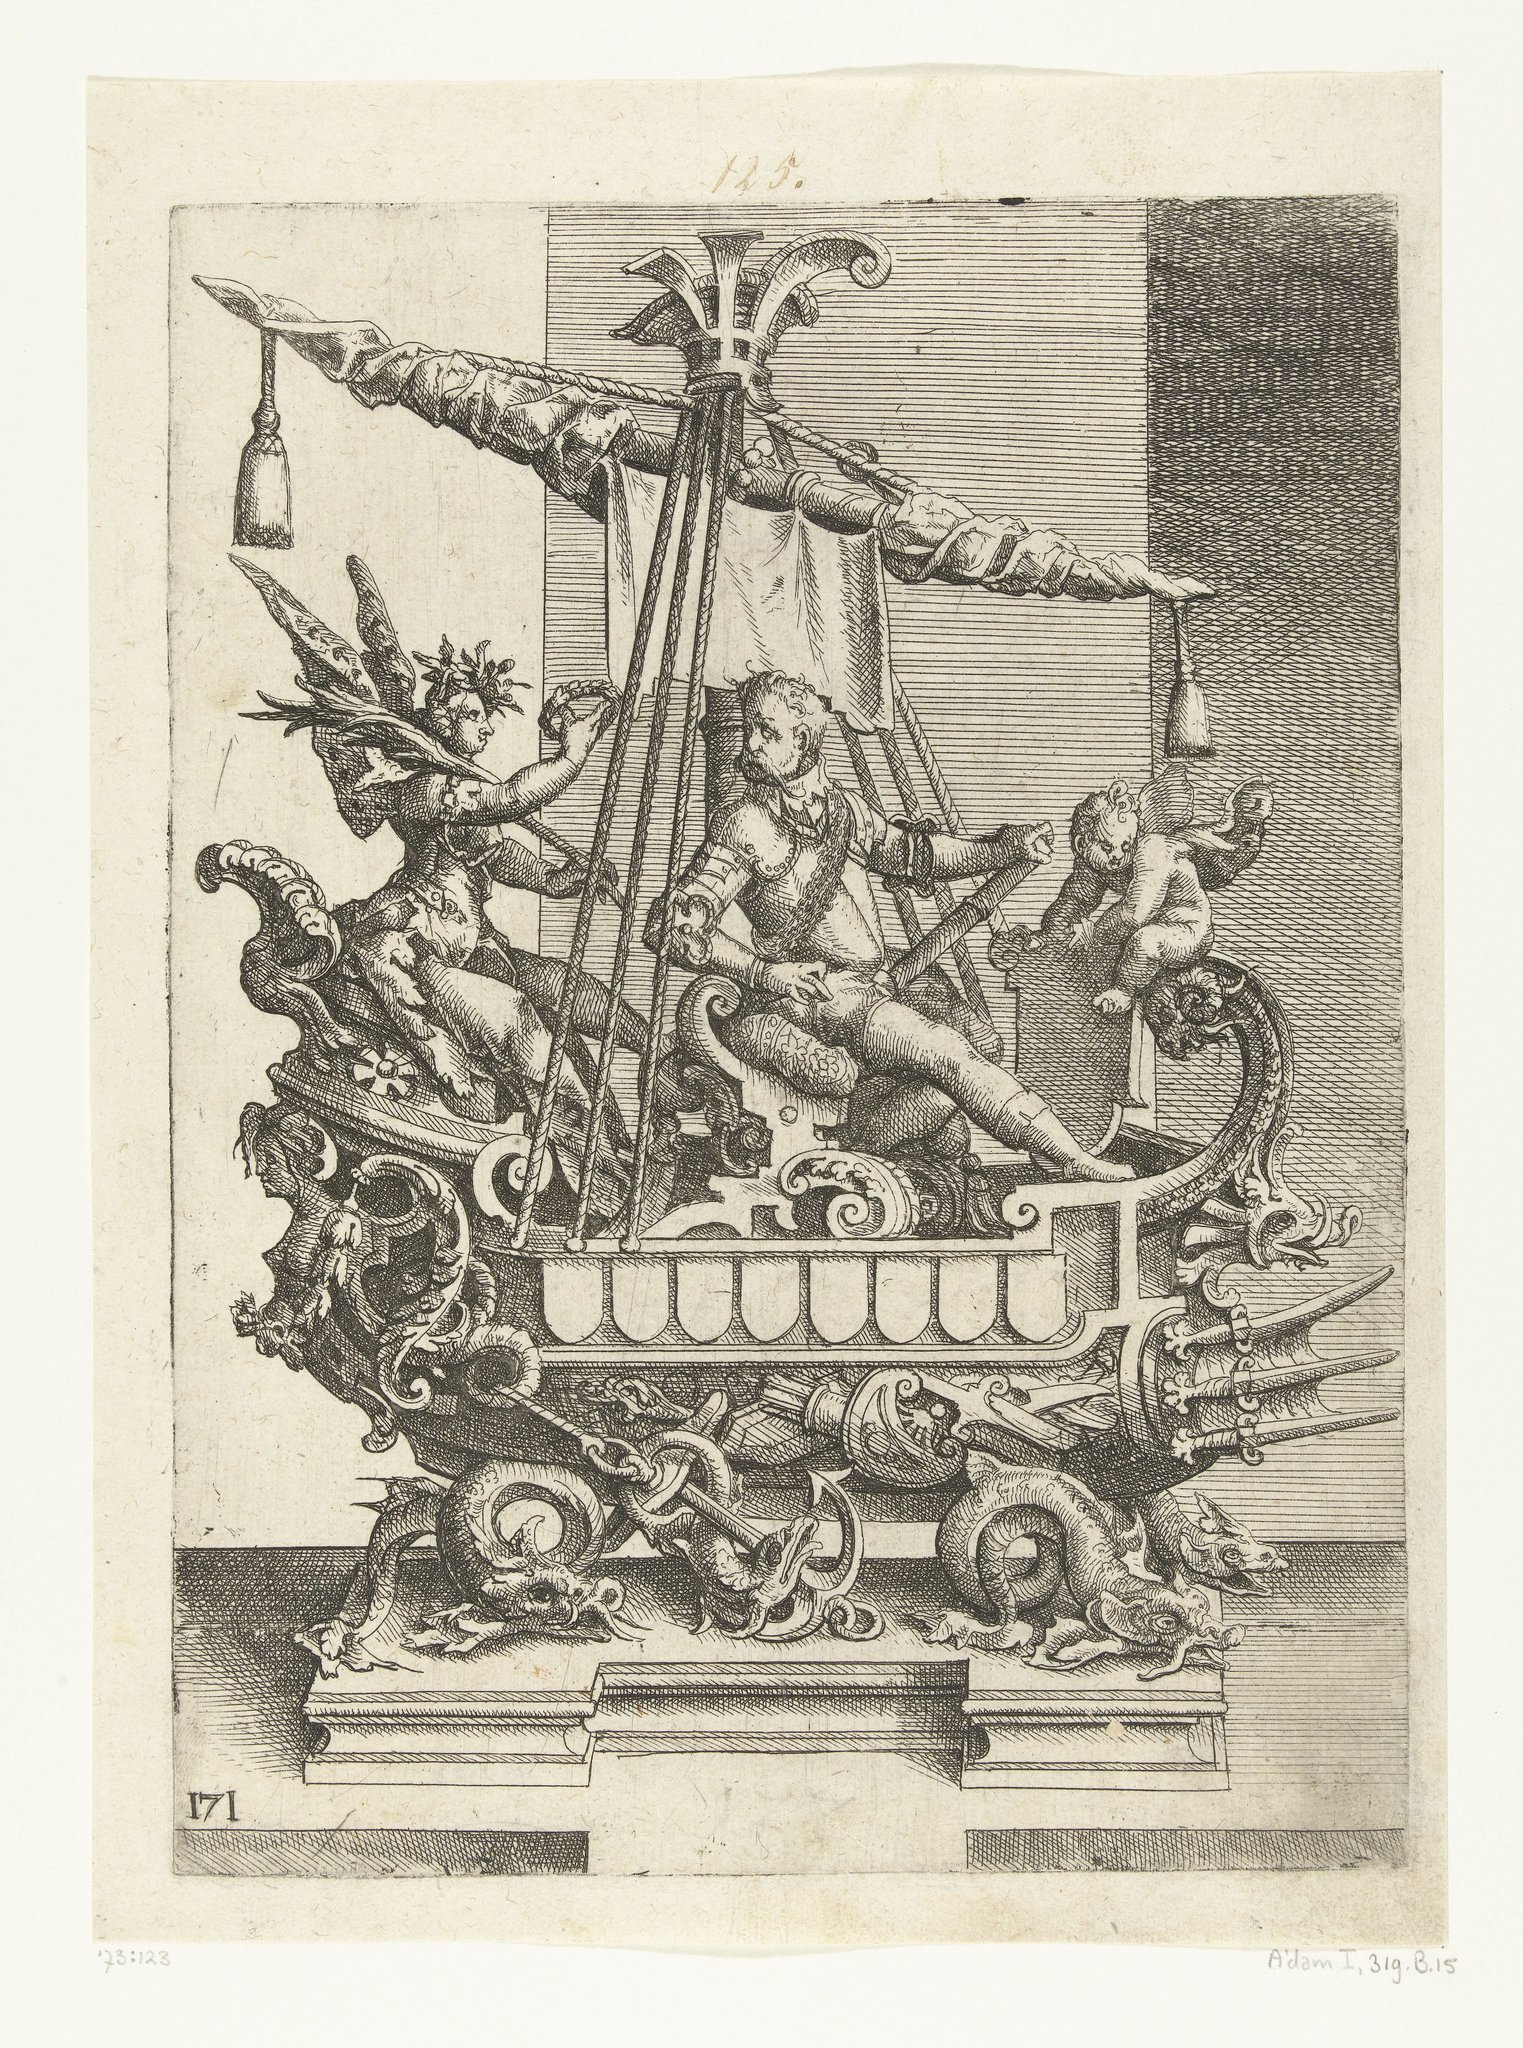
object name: ornament print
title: Fonteinen, waterputten, schoorsteenmantels, kapitelen, vensters en retabels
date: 1560-1598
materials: paper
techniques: etching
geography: germany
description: Op het dek van een schip, dat gedragen wordt door dolfijnen, zit een admiraal. Op de achterplecht zit Victoria die hem een krans boven het hoofd houdt. Eén van 20 bladen uit een serie (Architectura. Von Ausztheilung, Symmetria und Proportion der fünff Seulen...) bestaande uit 193 bladen en 5 titelbladen, verdeeld over vijf boeken. Het gaat hier om een tweede, uitgebreide editie van de onder Orn Cat I-319 beschreven serie.